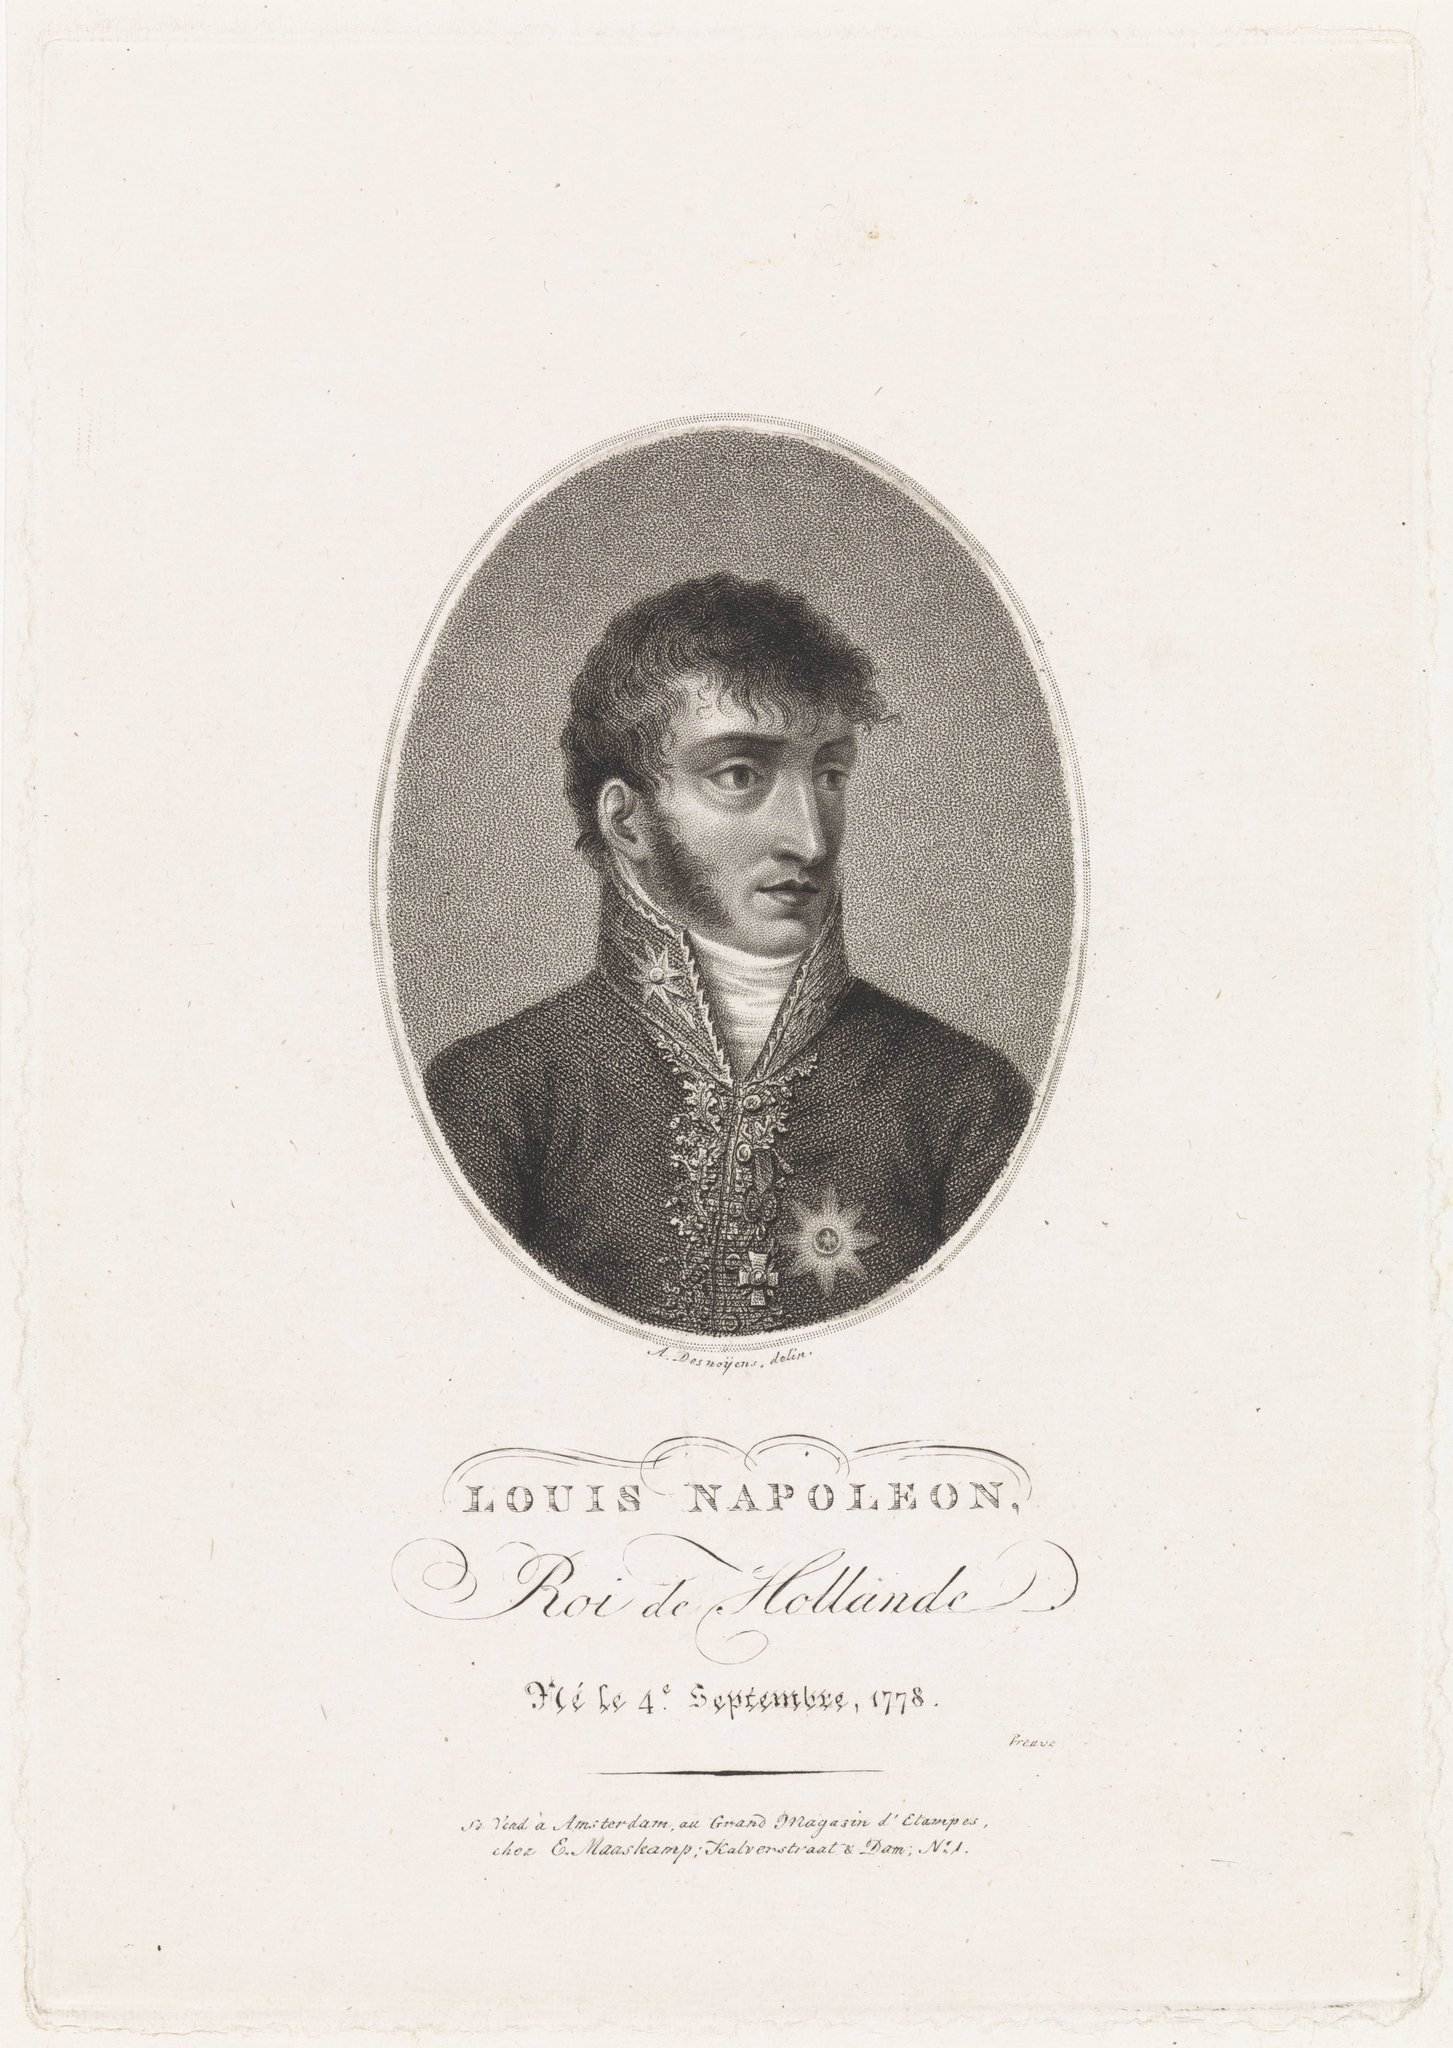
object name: print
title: Portret van Lodewijk Napoleon Bonaparte, koning van Holland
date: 1794-1828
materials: paper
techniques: stippled etching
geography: amsterdam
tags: louis napoleon (king of holland), knighthood order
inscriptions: collector's mark: Lugt 2228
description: Hij draagt een ster van de Orde van de Unie.